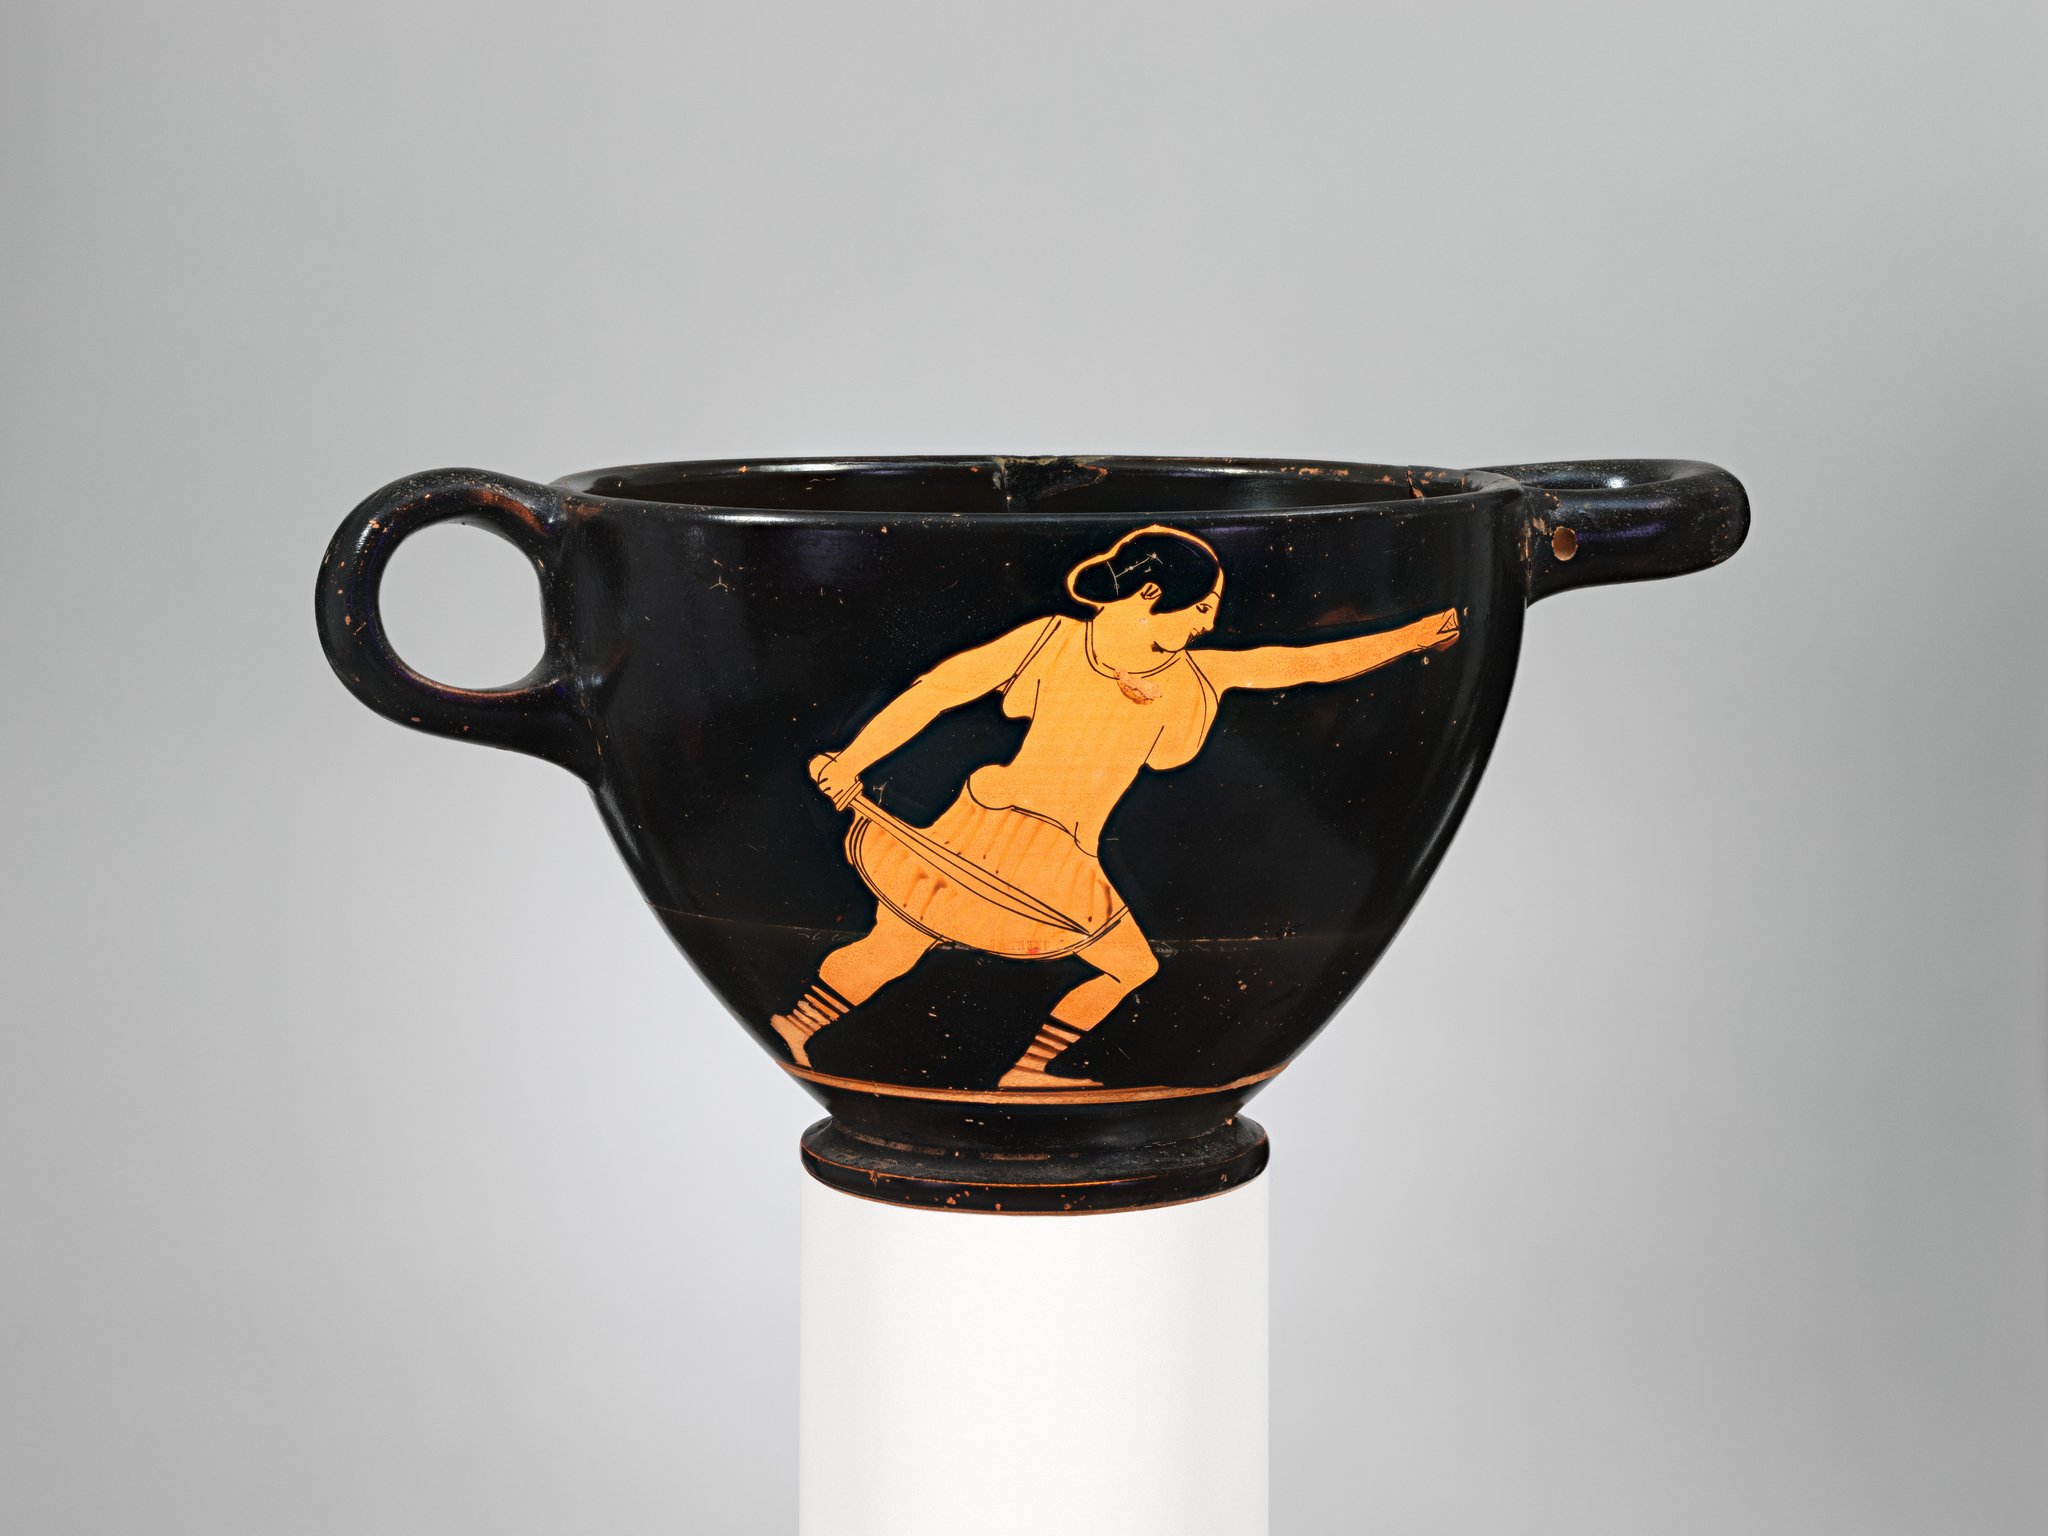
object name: skyphos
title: Terracotta skyphos (deep drinking cup)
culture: greek, attic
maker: pan painter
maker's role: artist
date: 470-460 BCE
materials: terracotta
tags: theseus,minotaurs